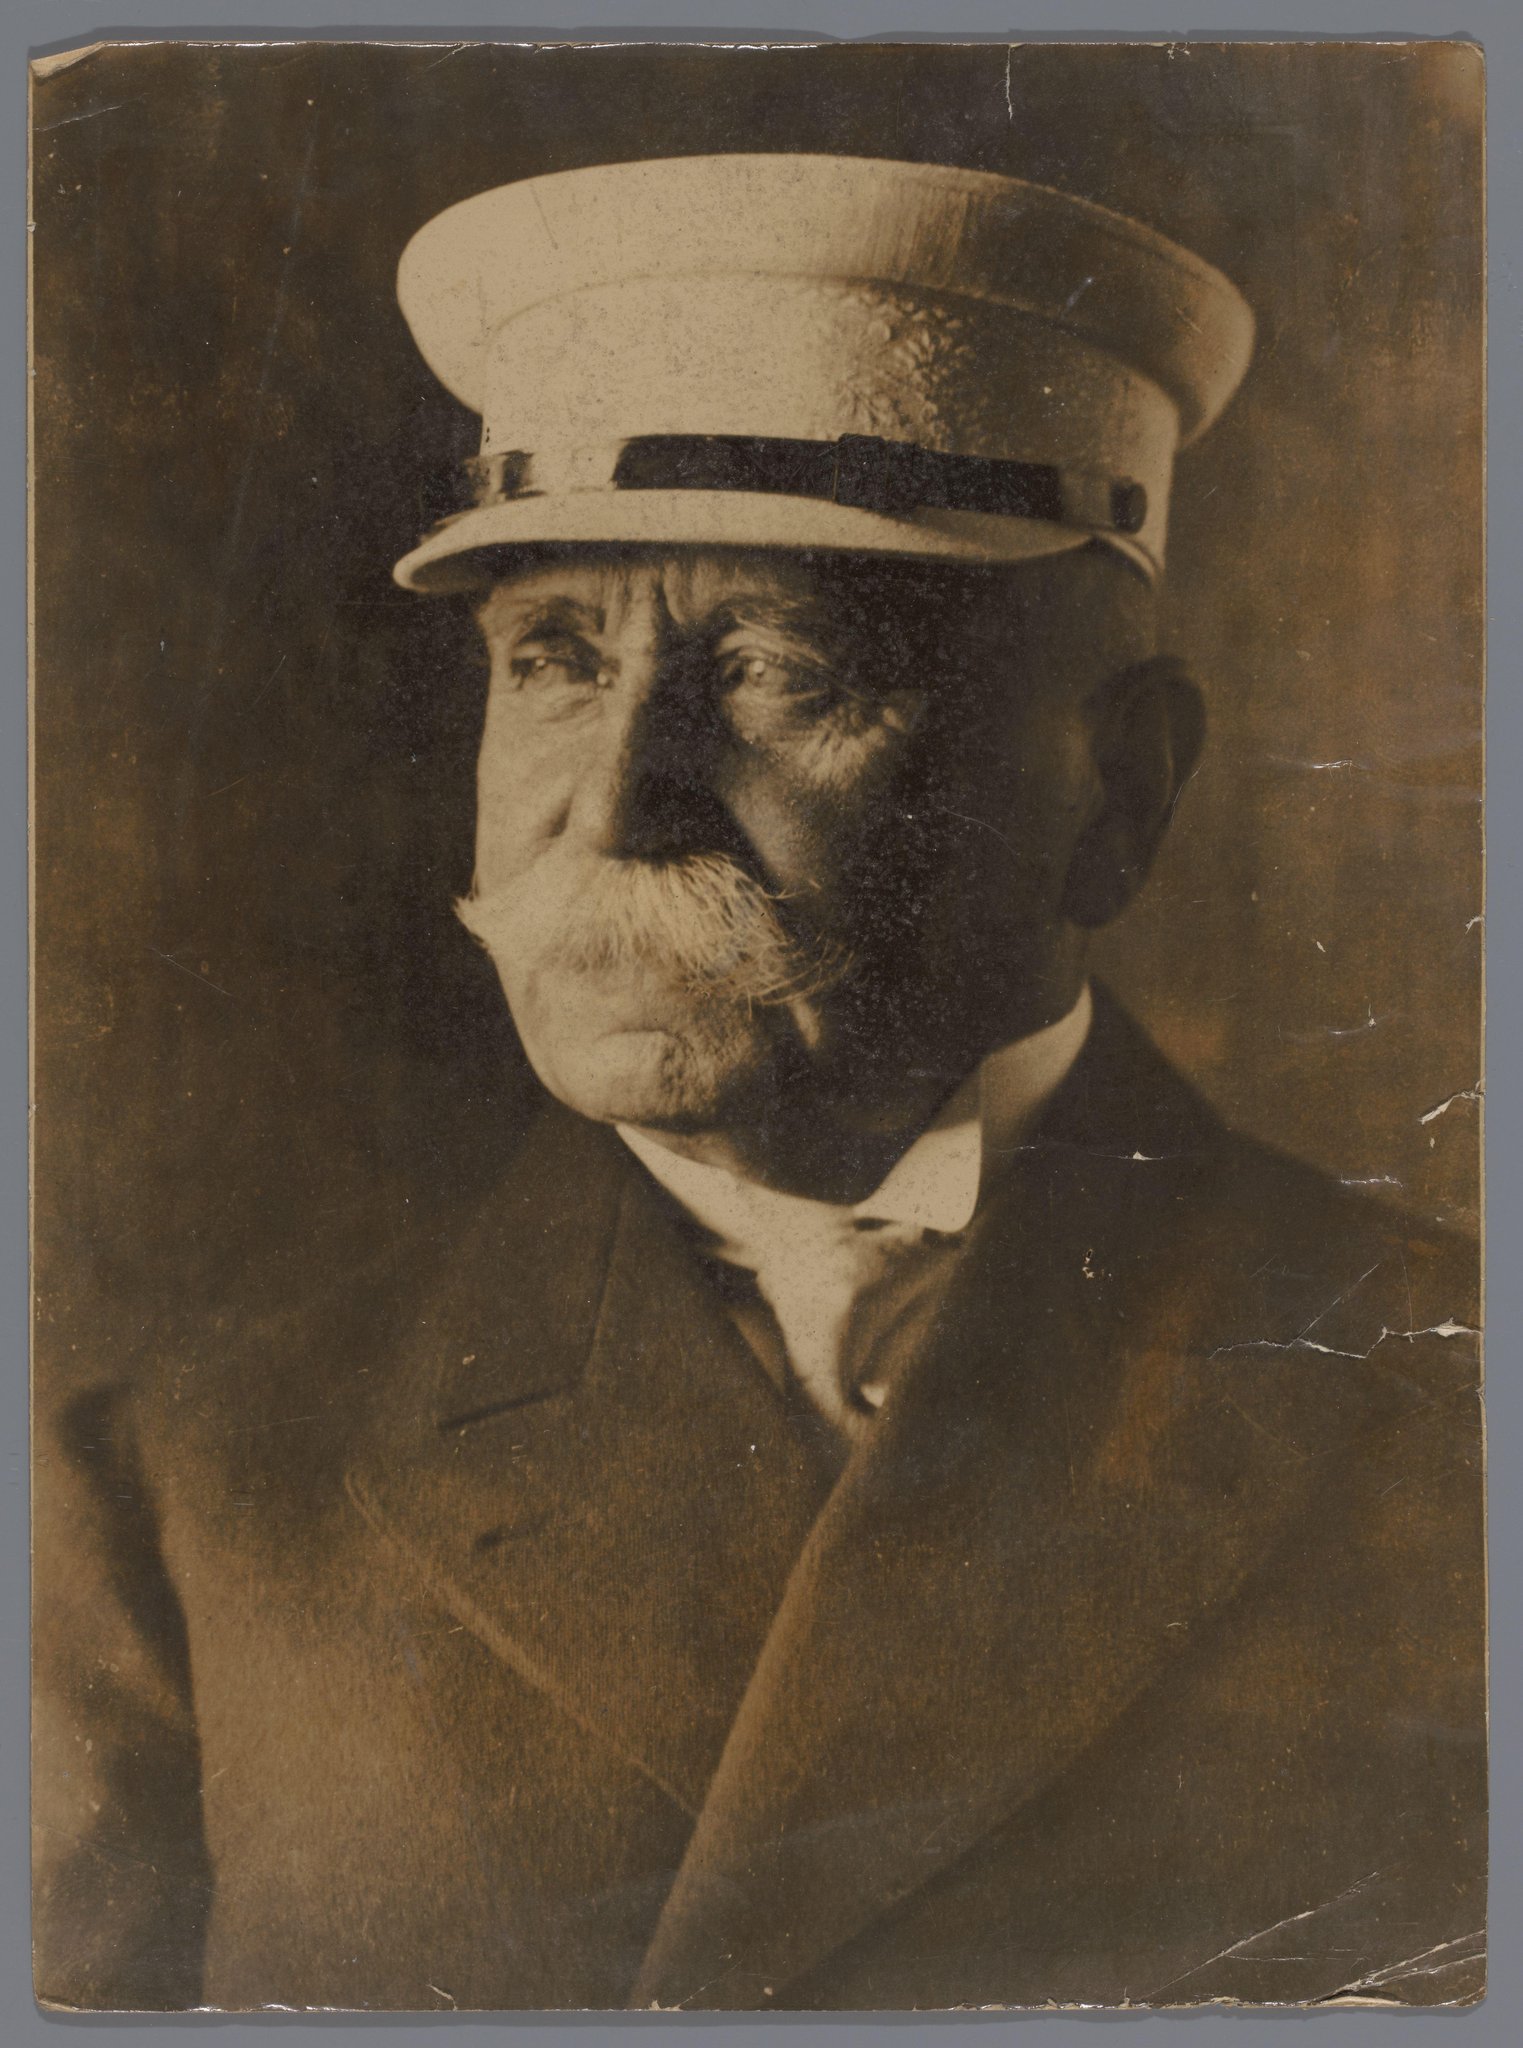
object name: photograph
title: Portret van Ferdinand von Zeppelin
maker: Anonymous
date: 1900-1917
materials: paper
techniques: gelatin silver print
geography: amsterdam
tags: berlin, engineer, historical persons, old man, germany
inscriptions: inscription: ‘Ferdinand Graf von Zeppelin/ 2,50’, stamp: ‘Copyright/ Fotobureau/ "Holland"/ Fr. v. Mierisstraat 64 (...)’